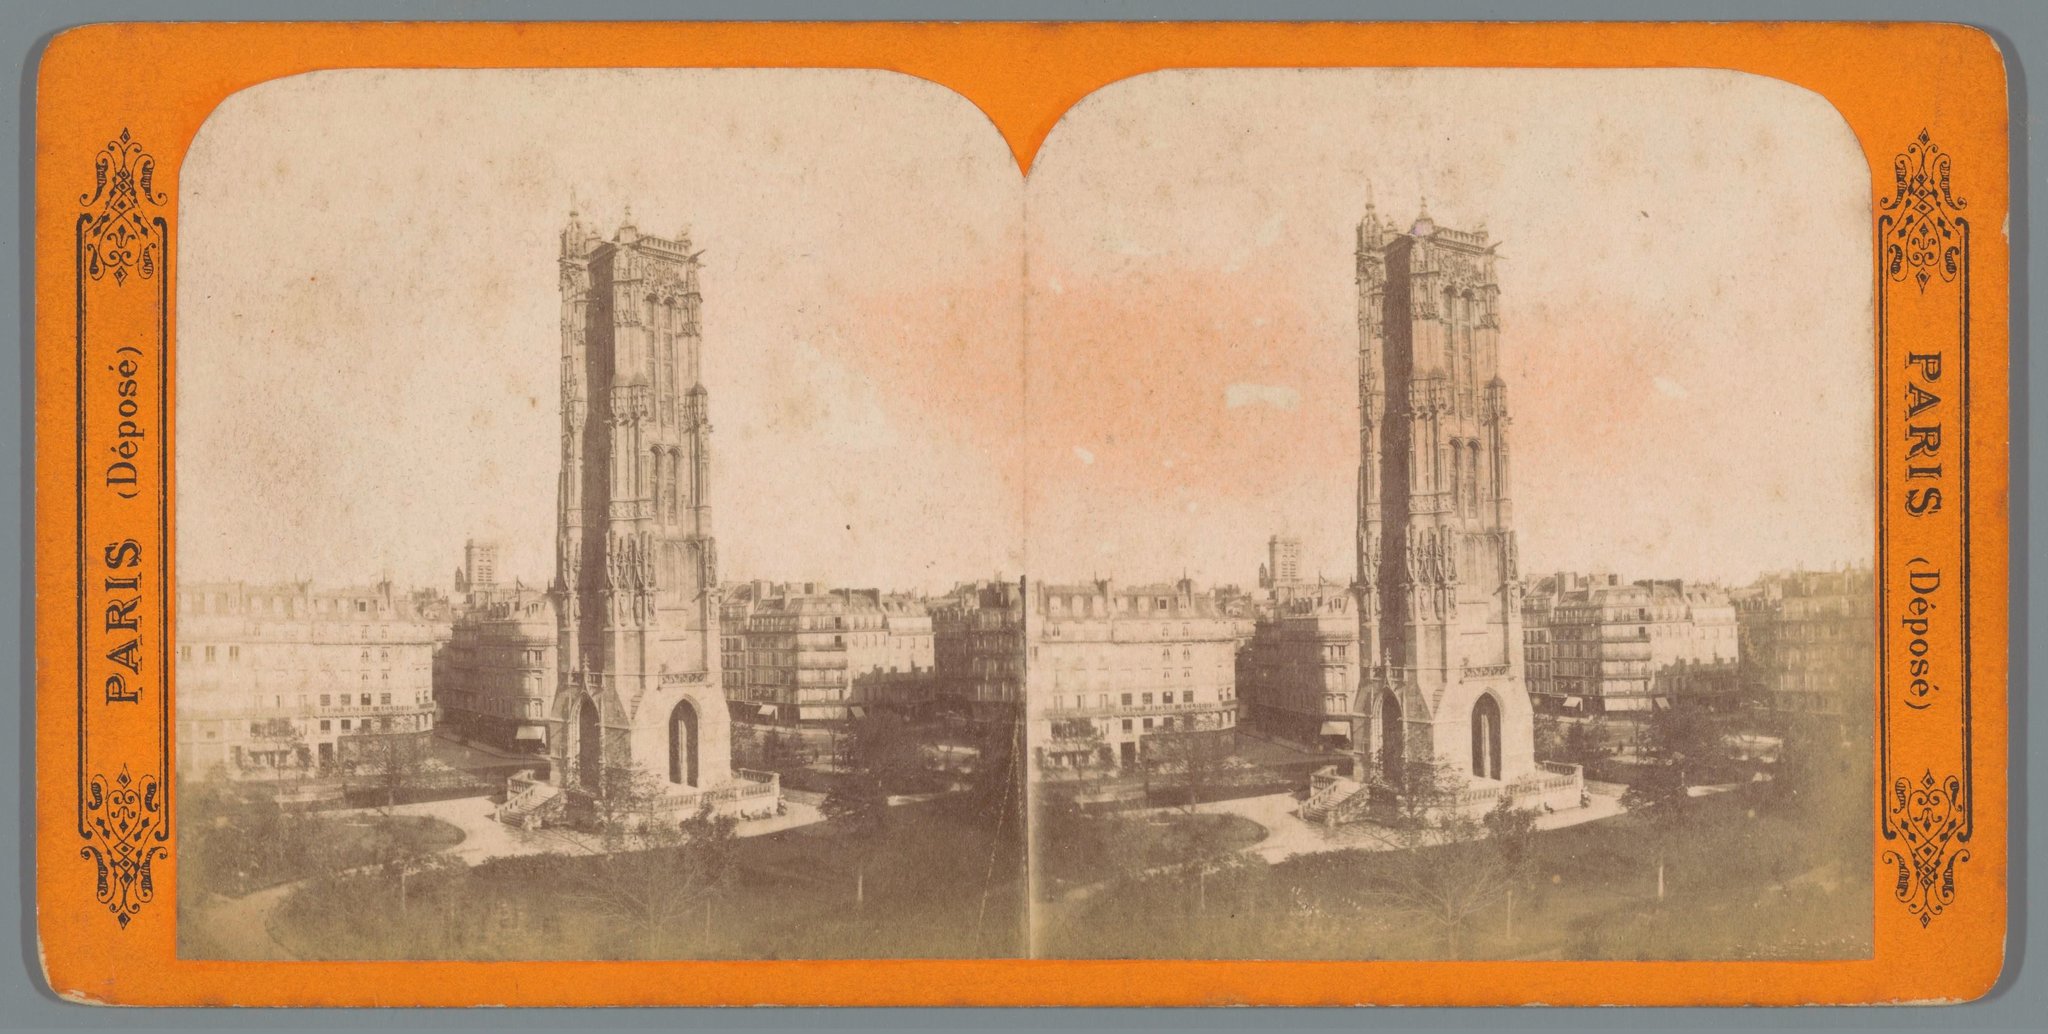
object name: stereograph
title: Paris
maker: Anonymous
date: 1850-1880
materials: cardboard, photographic support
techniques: albumen print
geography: paris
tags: tower, clock tower ~ monumental adornment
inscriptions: inscription: ‘Paris Tour St. Jacques (= van afgebroken kerk St. Jacques-la-Boucherie)’